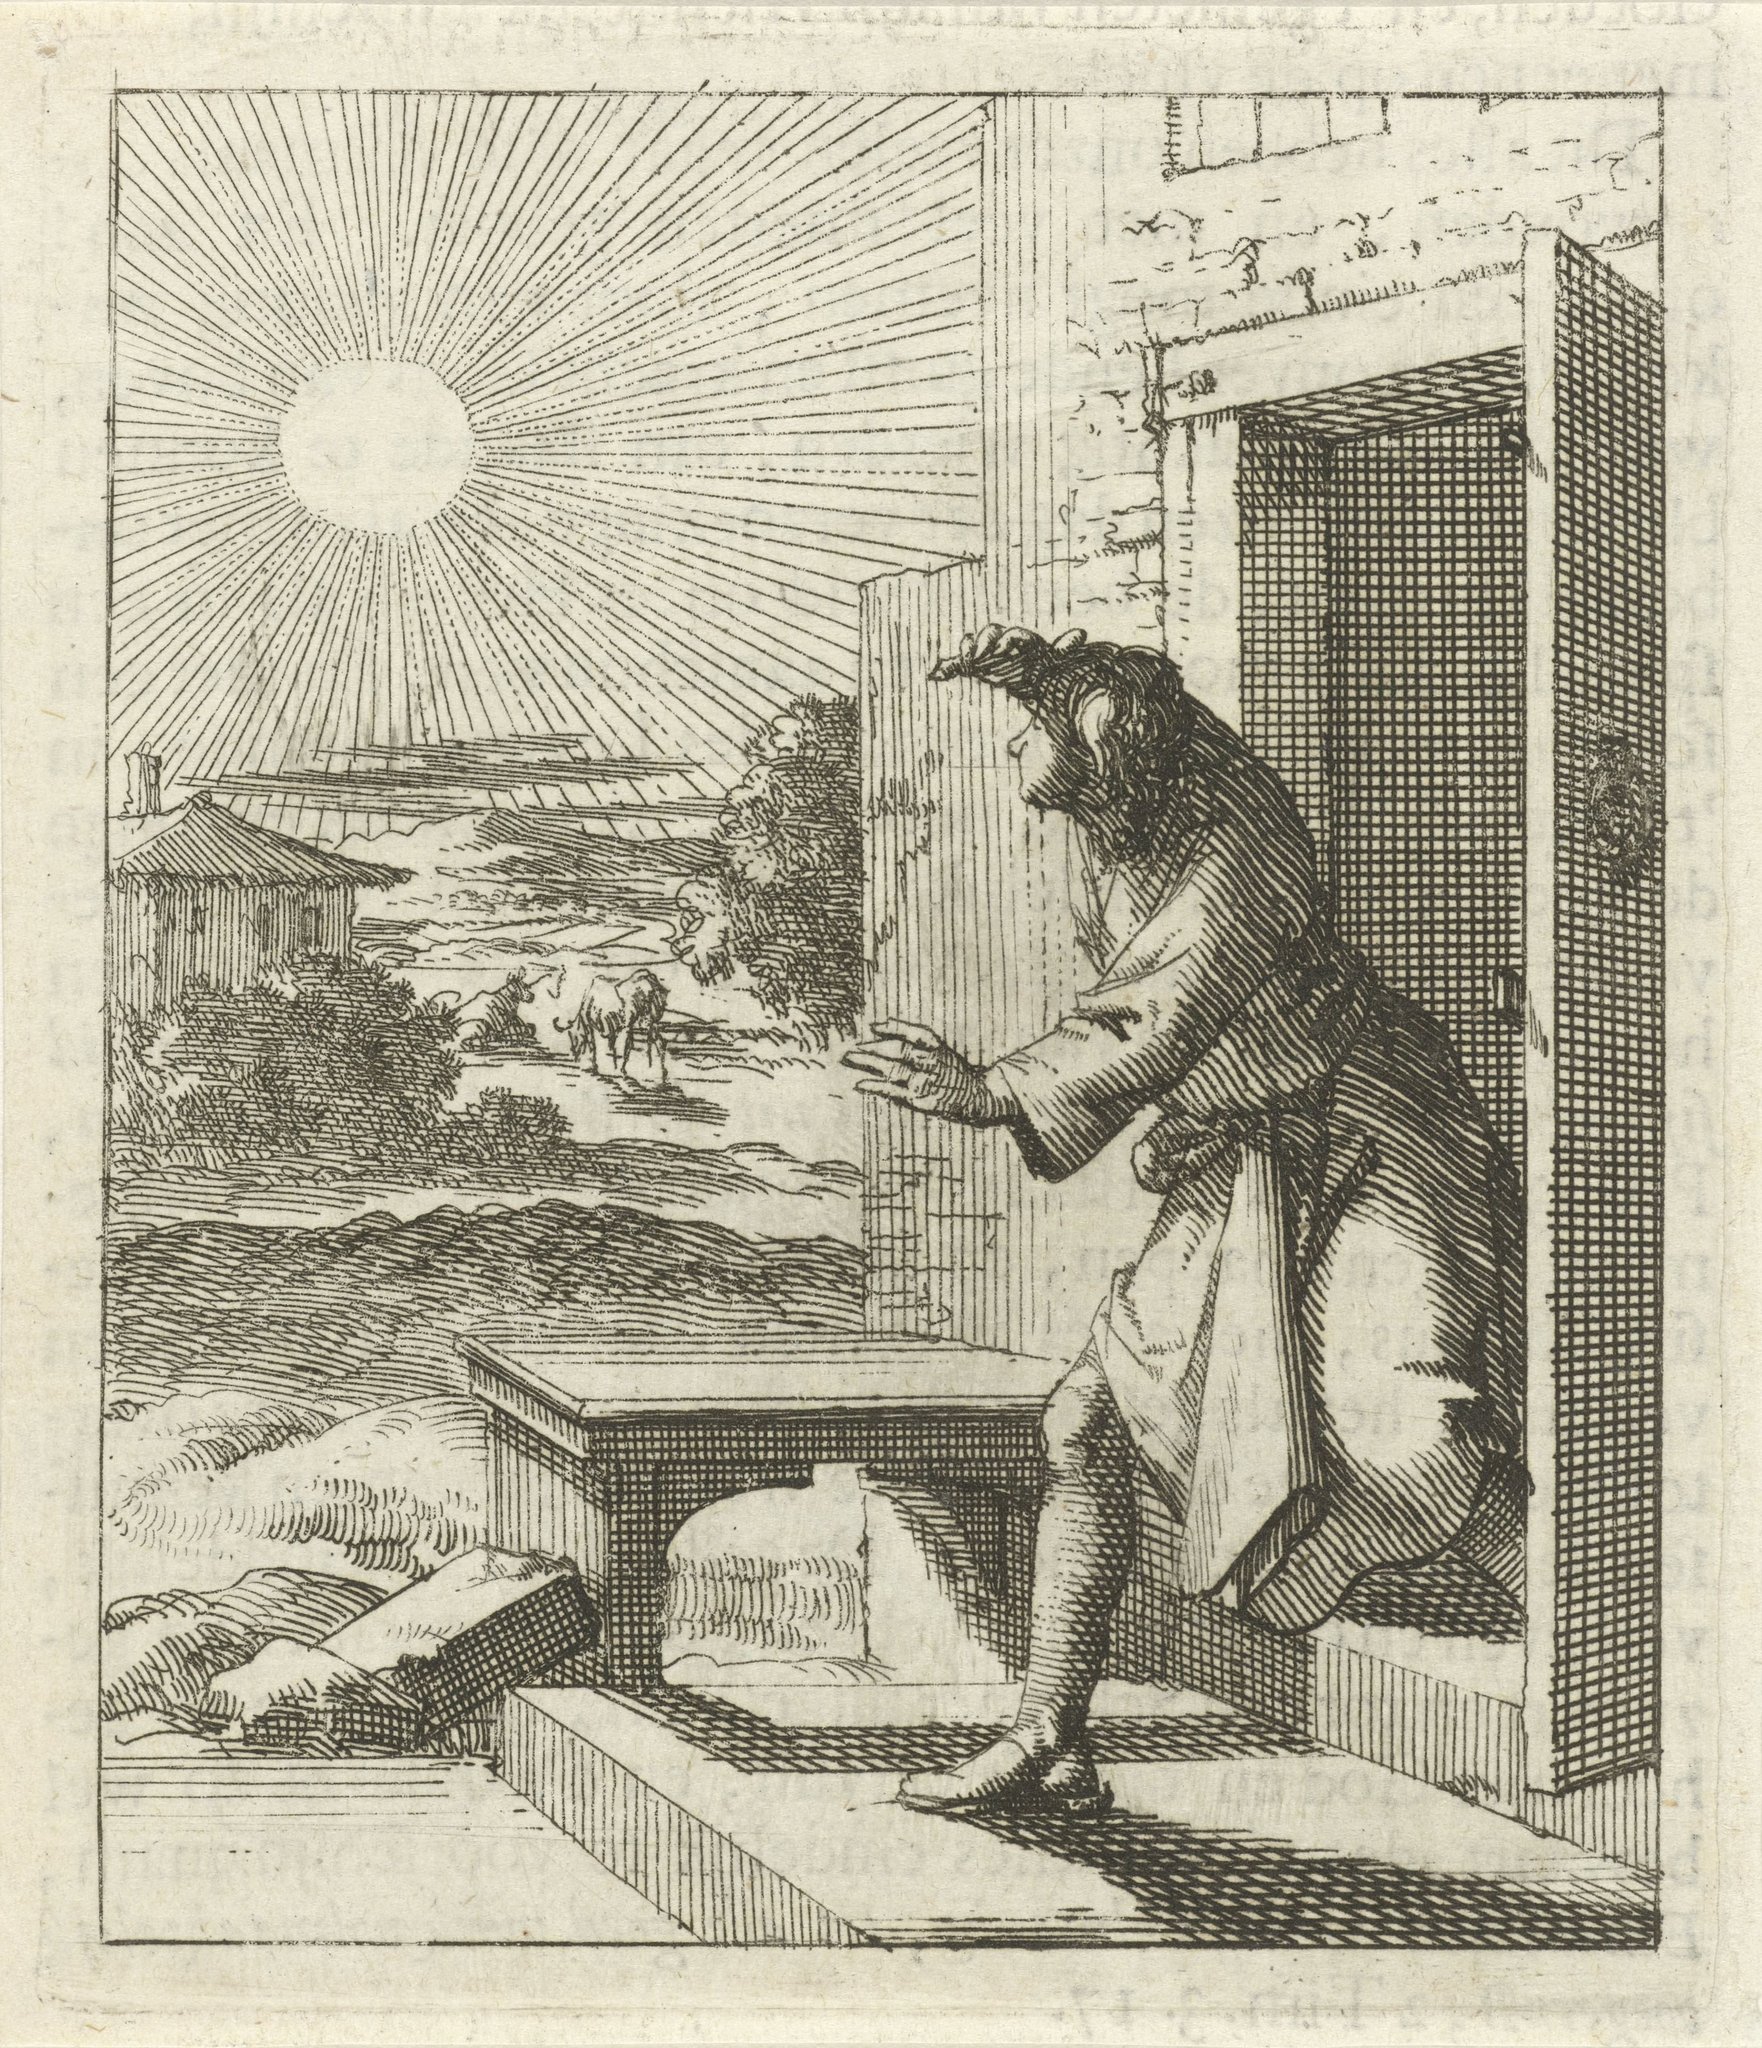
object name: book illustration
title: Gods aangename Zon Is aller levens Bron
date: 1689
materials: paper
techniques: etching, letterpress printing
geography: amsterdam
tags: hand(s) towards the eye(s) (+ protecting), sunlight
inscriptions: collector's mark: Lugt 2228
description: Illustratie uit: Huygen, Pieter. De beginselen van Gods koninkryk in den mensch uitgedrukt in zinnebeelden. Amsterdam: wed. Arentsz. Pieter (II), 1689, p. 140.